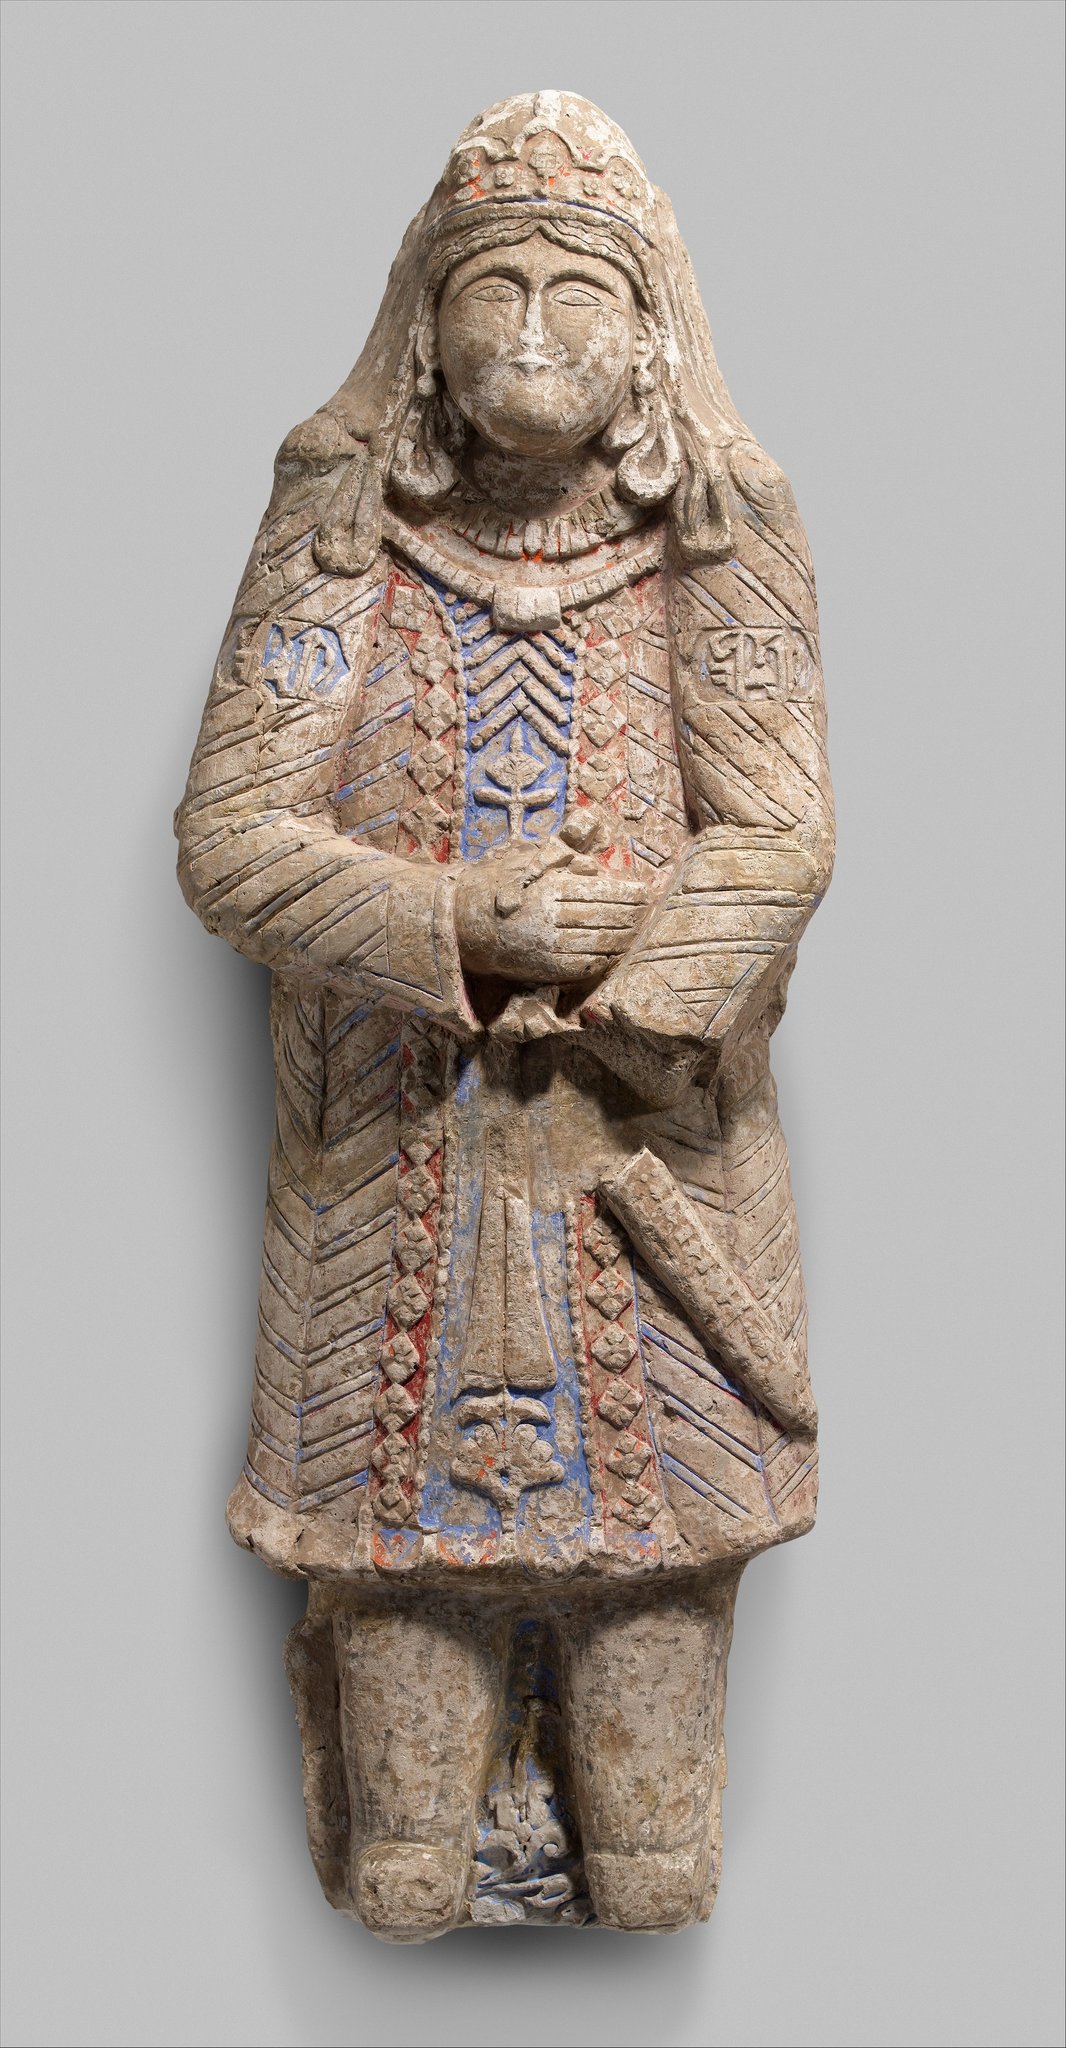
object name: figure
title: Standing Figure with Jeweled Headdress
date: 1101-1233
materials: gypsum, plaster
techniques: carving, gilding, painting, polychrome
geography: iran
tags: men